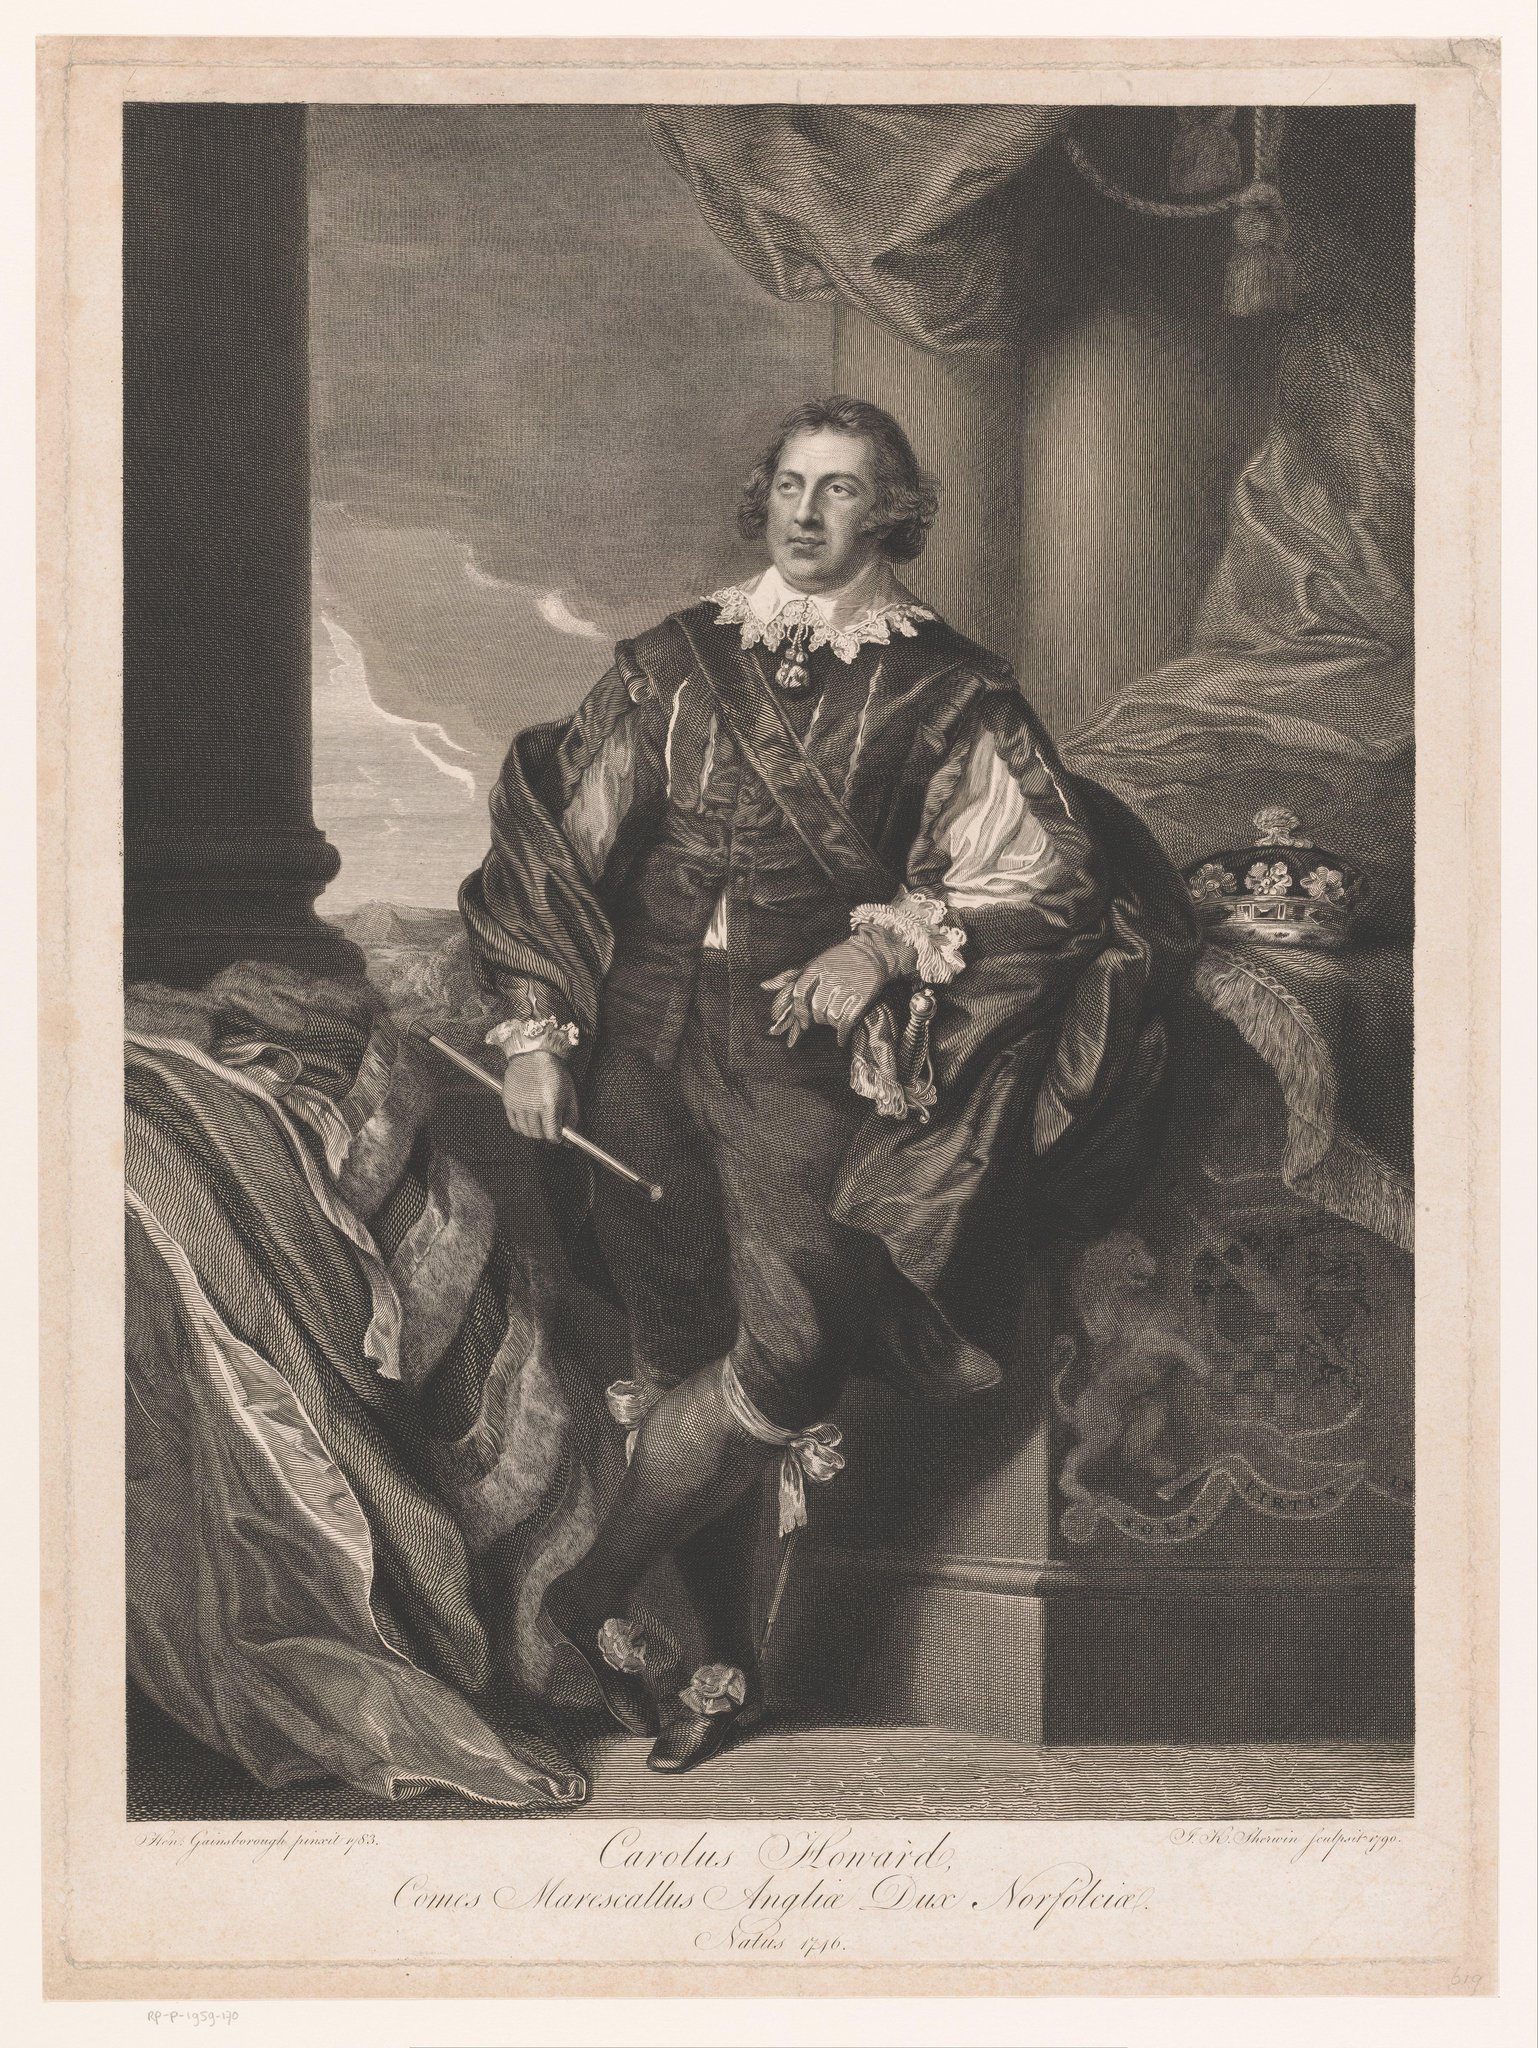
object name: print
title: Portret van Charles Howard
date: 1790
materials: paper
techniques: engraving, etching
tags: politician, crown (symbol of sovereignty), historical persons, politician, e.g. party leader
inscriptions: collector's mark: Lugt 2228, collector's mark: Lugt 2760